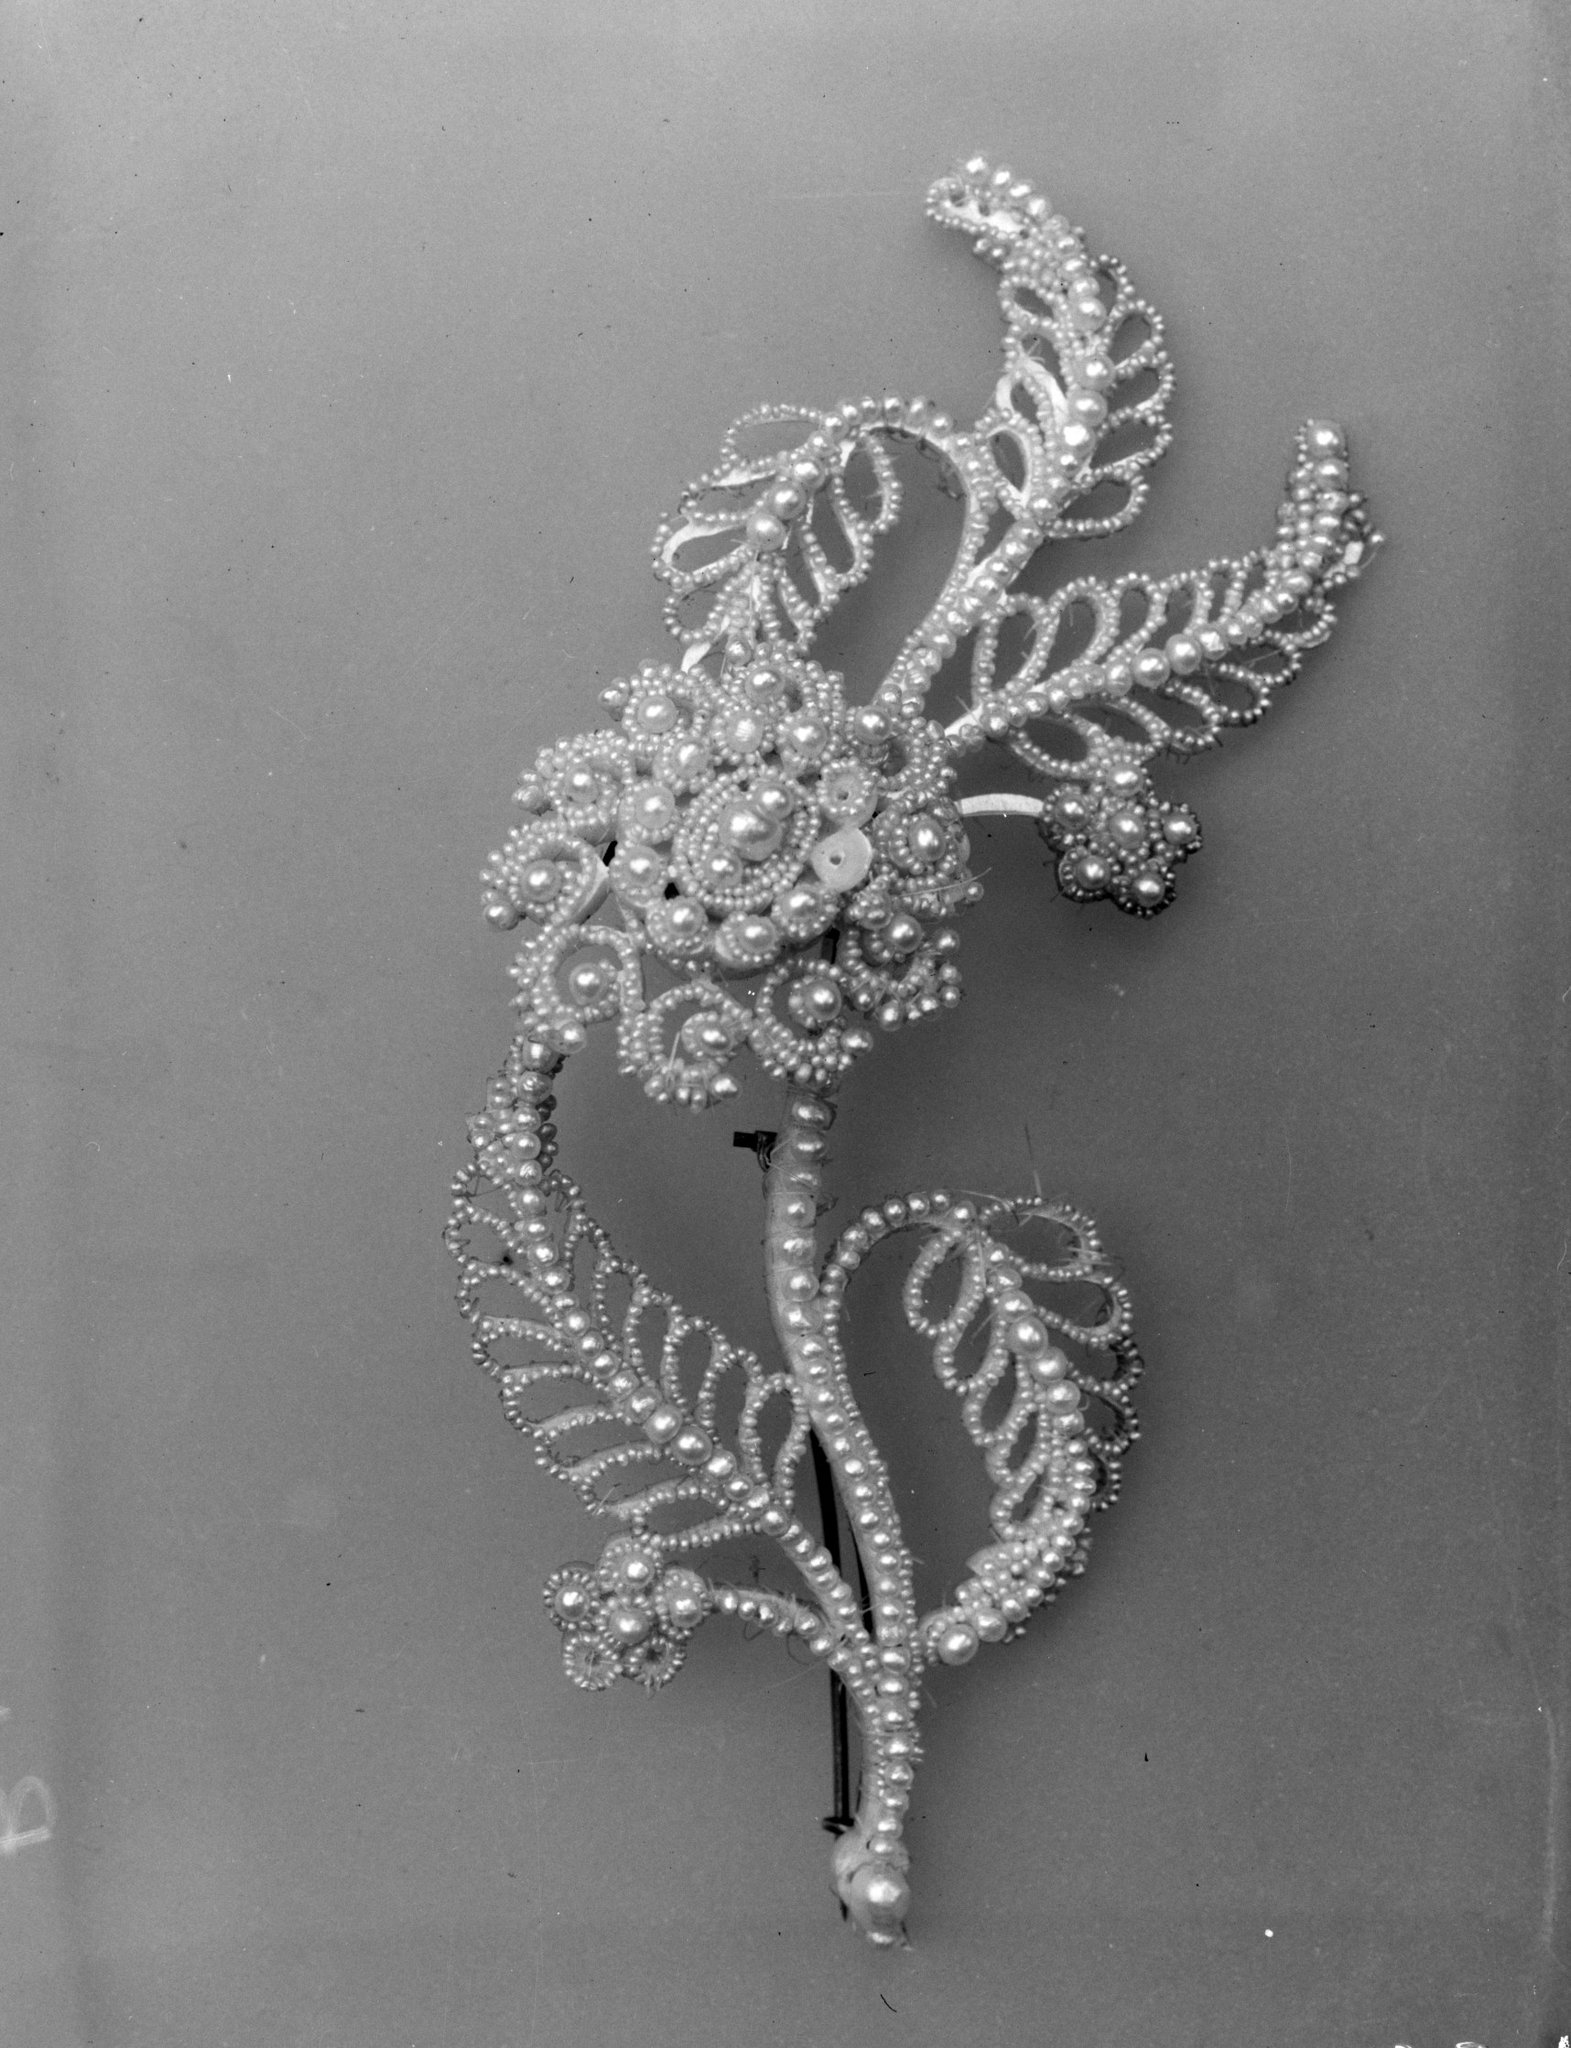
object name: brooch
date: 1800-1900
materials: gold, pearl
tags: flowers